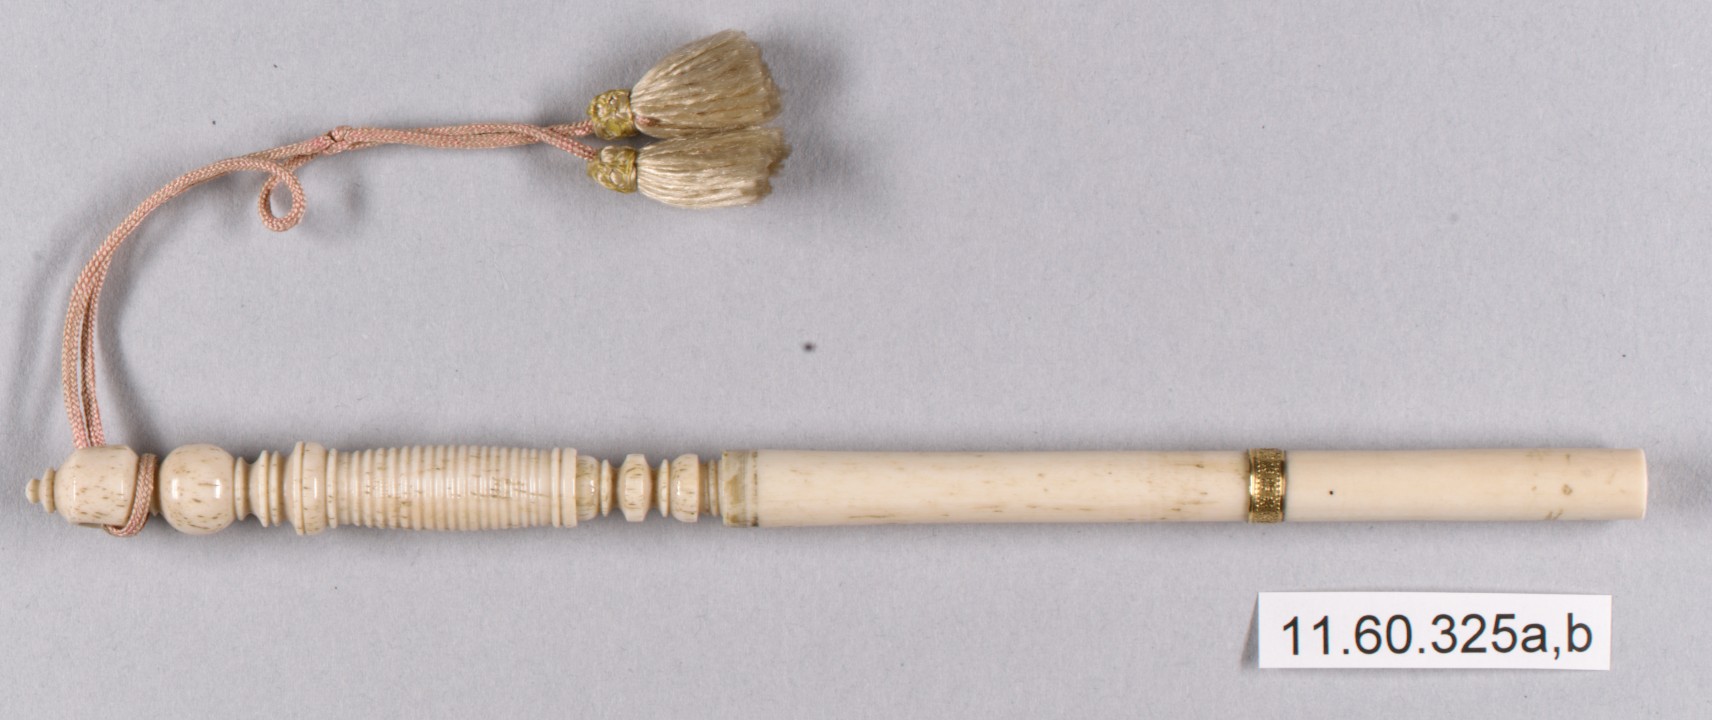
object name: needle case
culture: american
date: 1800-1830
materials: gold, ivory